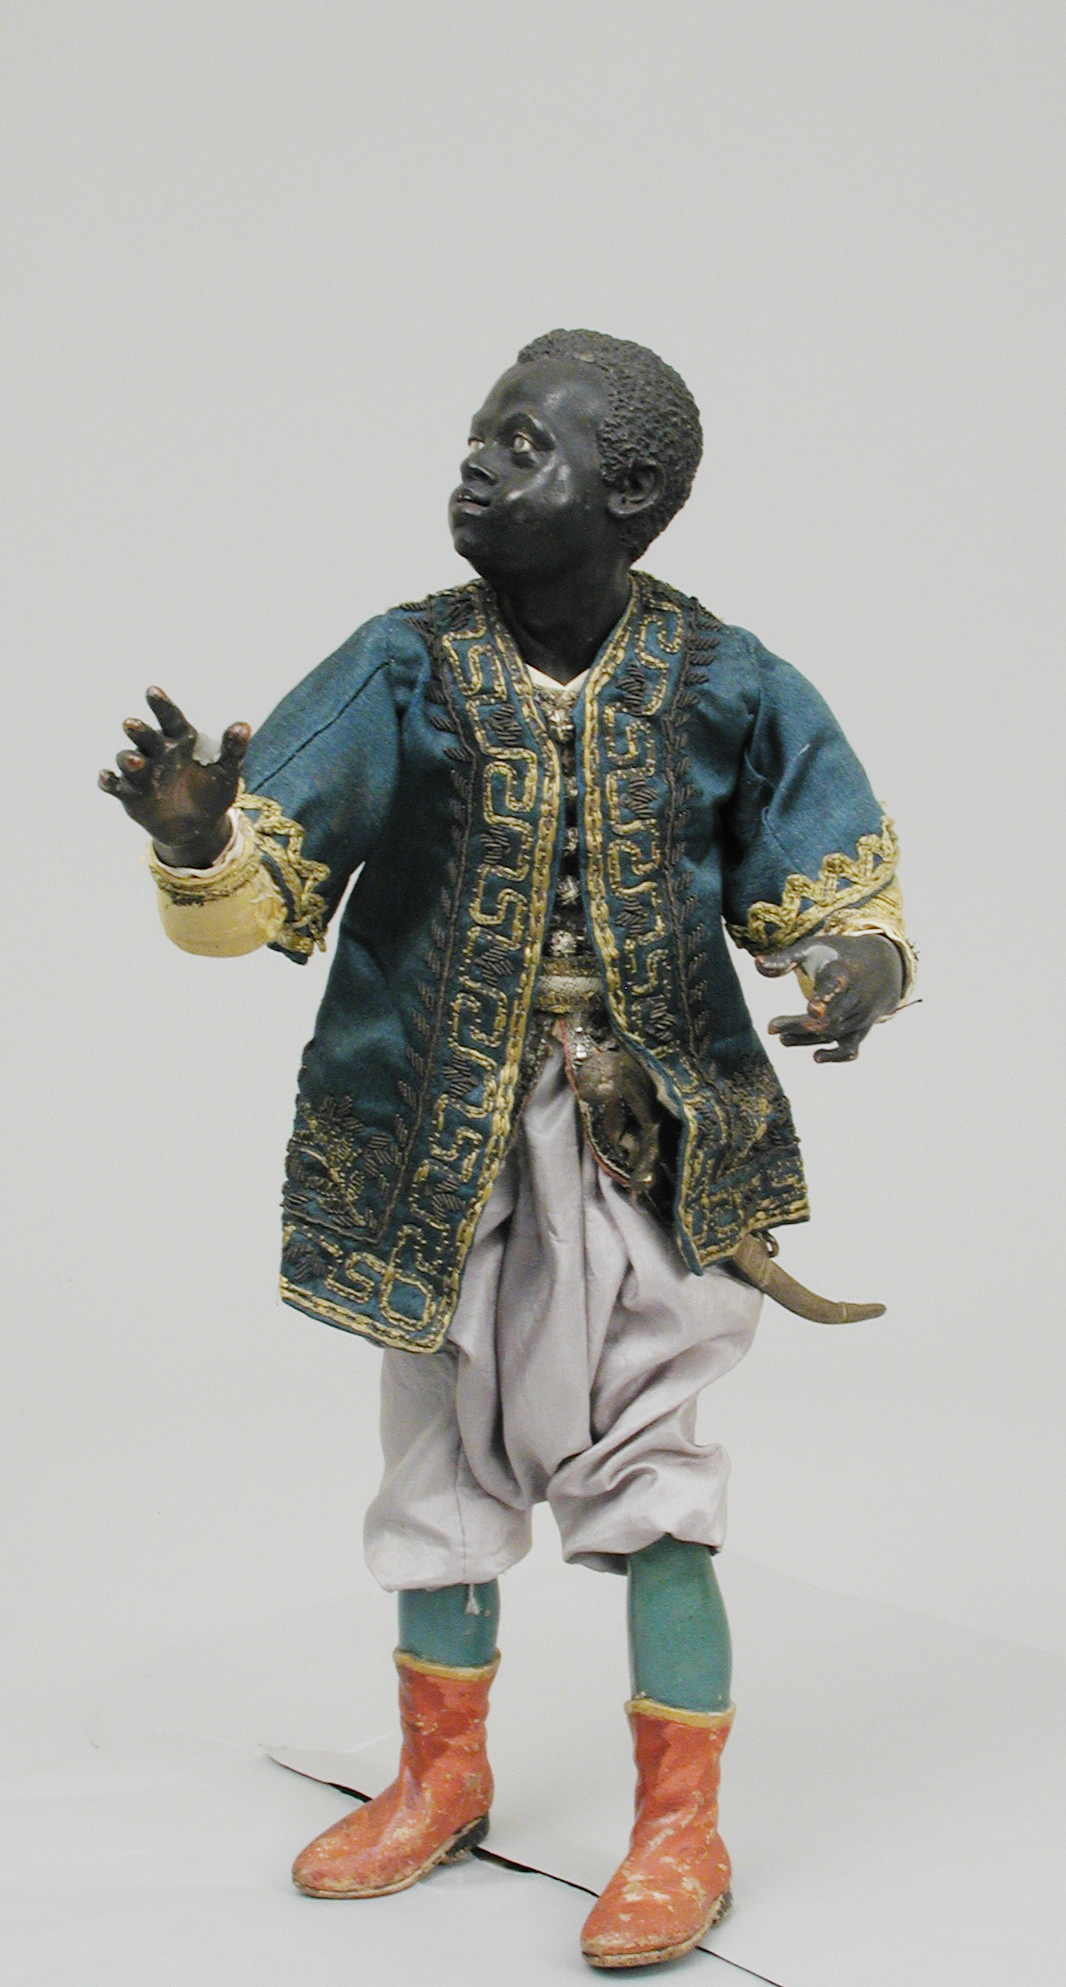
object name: crèche figure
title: King's Moorish attendant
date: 1751-1800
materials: cotton, gold, metal thread, textile, silk, silver, terracotta, fiber, metal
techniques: polychrome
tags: daggers,men